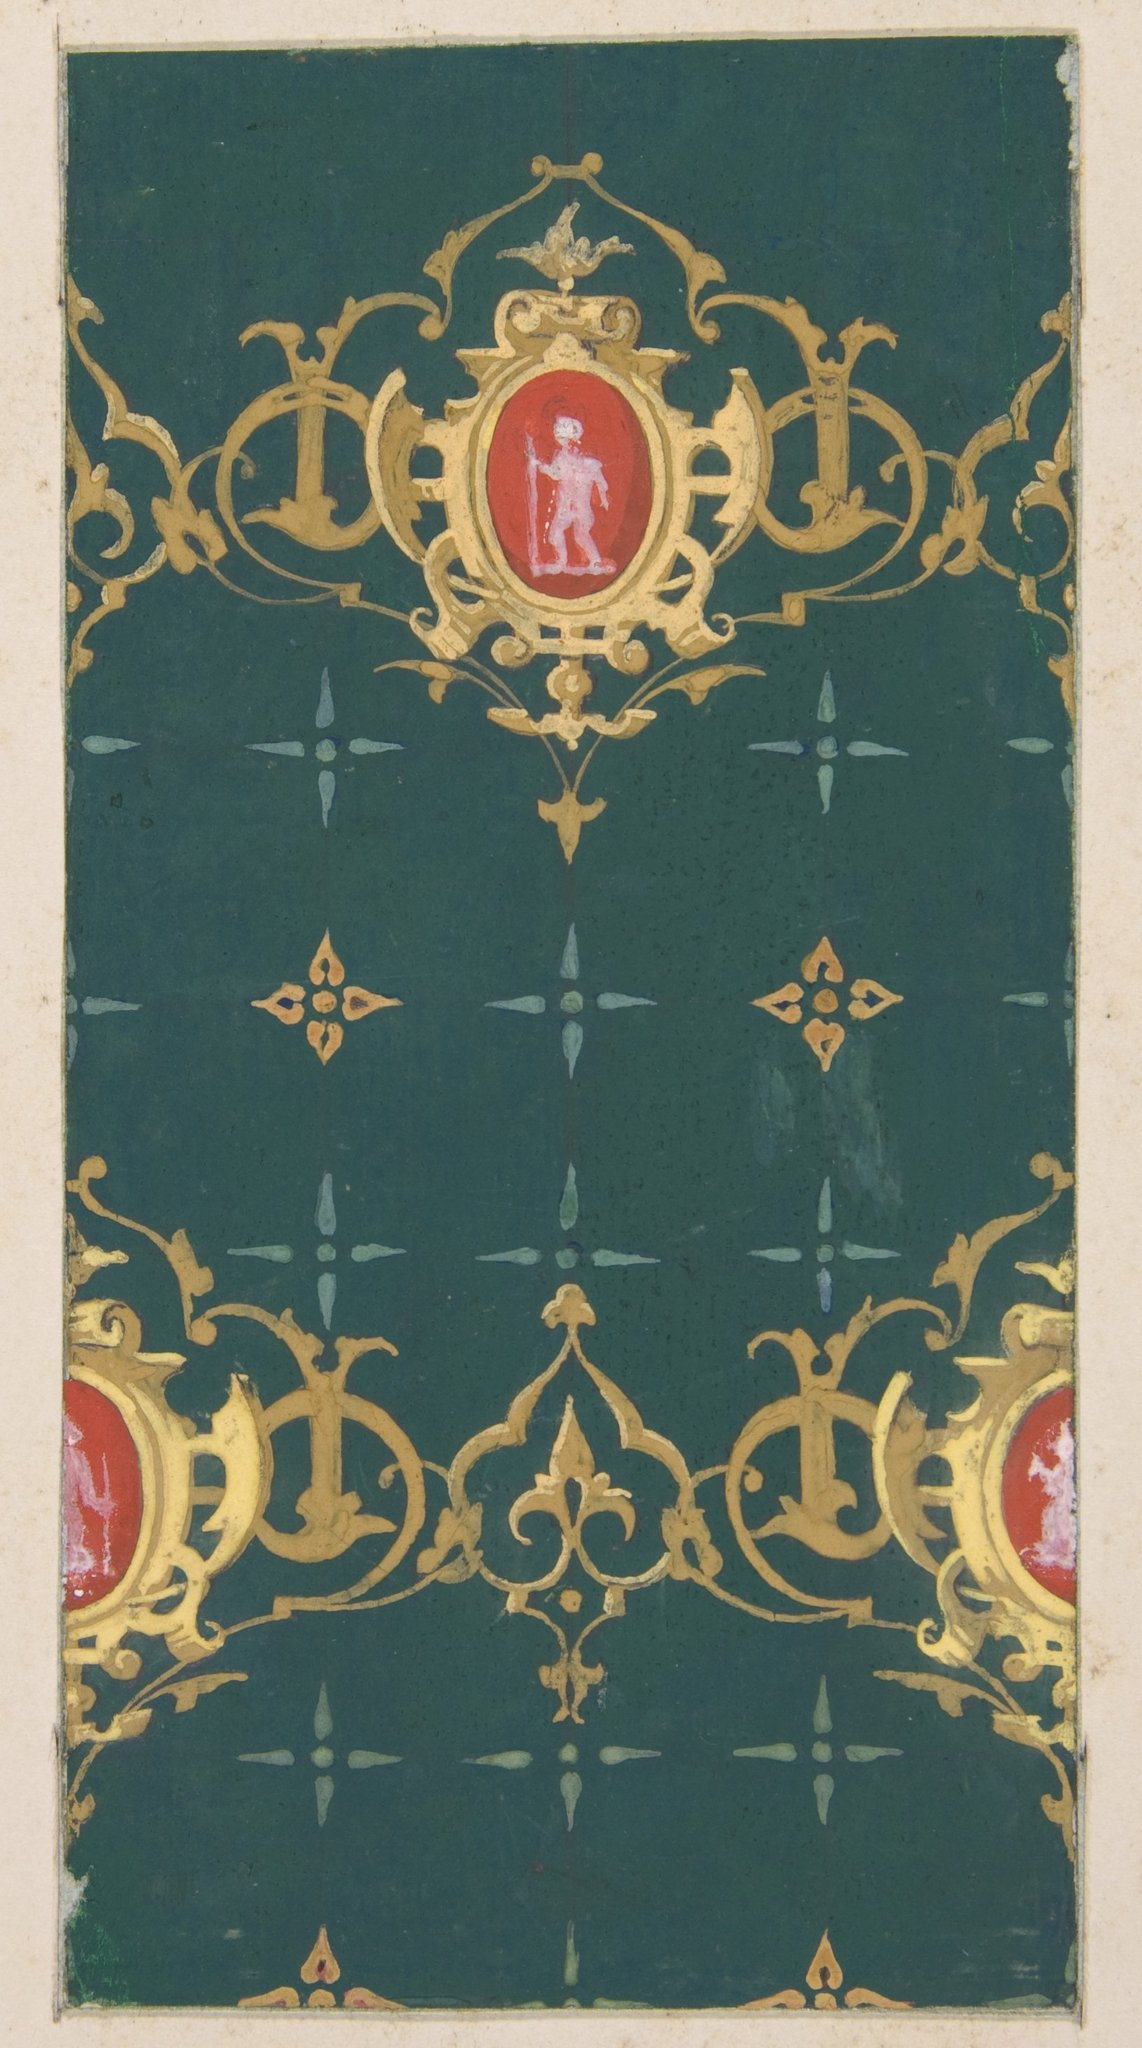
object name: drawing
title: Design for wallpaper featuring rinceaux and carouches framing figures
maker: jules-edmond-charles lachaise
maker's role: artist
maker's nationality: french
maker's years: 1897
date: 1830-1897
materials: gouache, paper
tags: human figures,cartouches